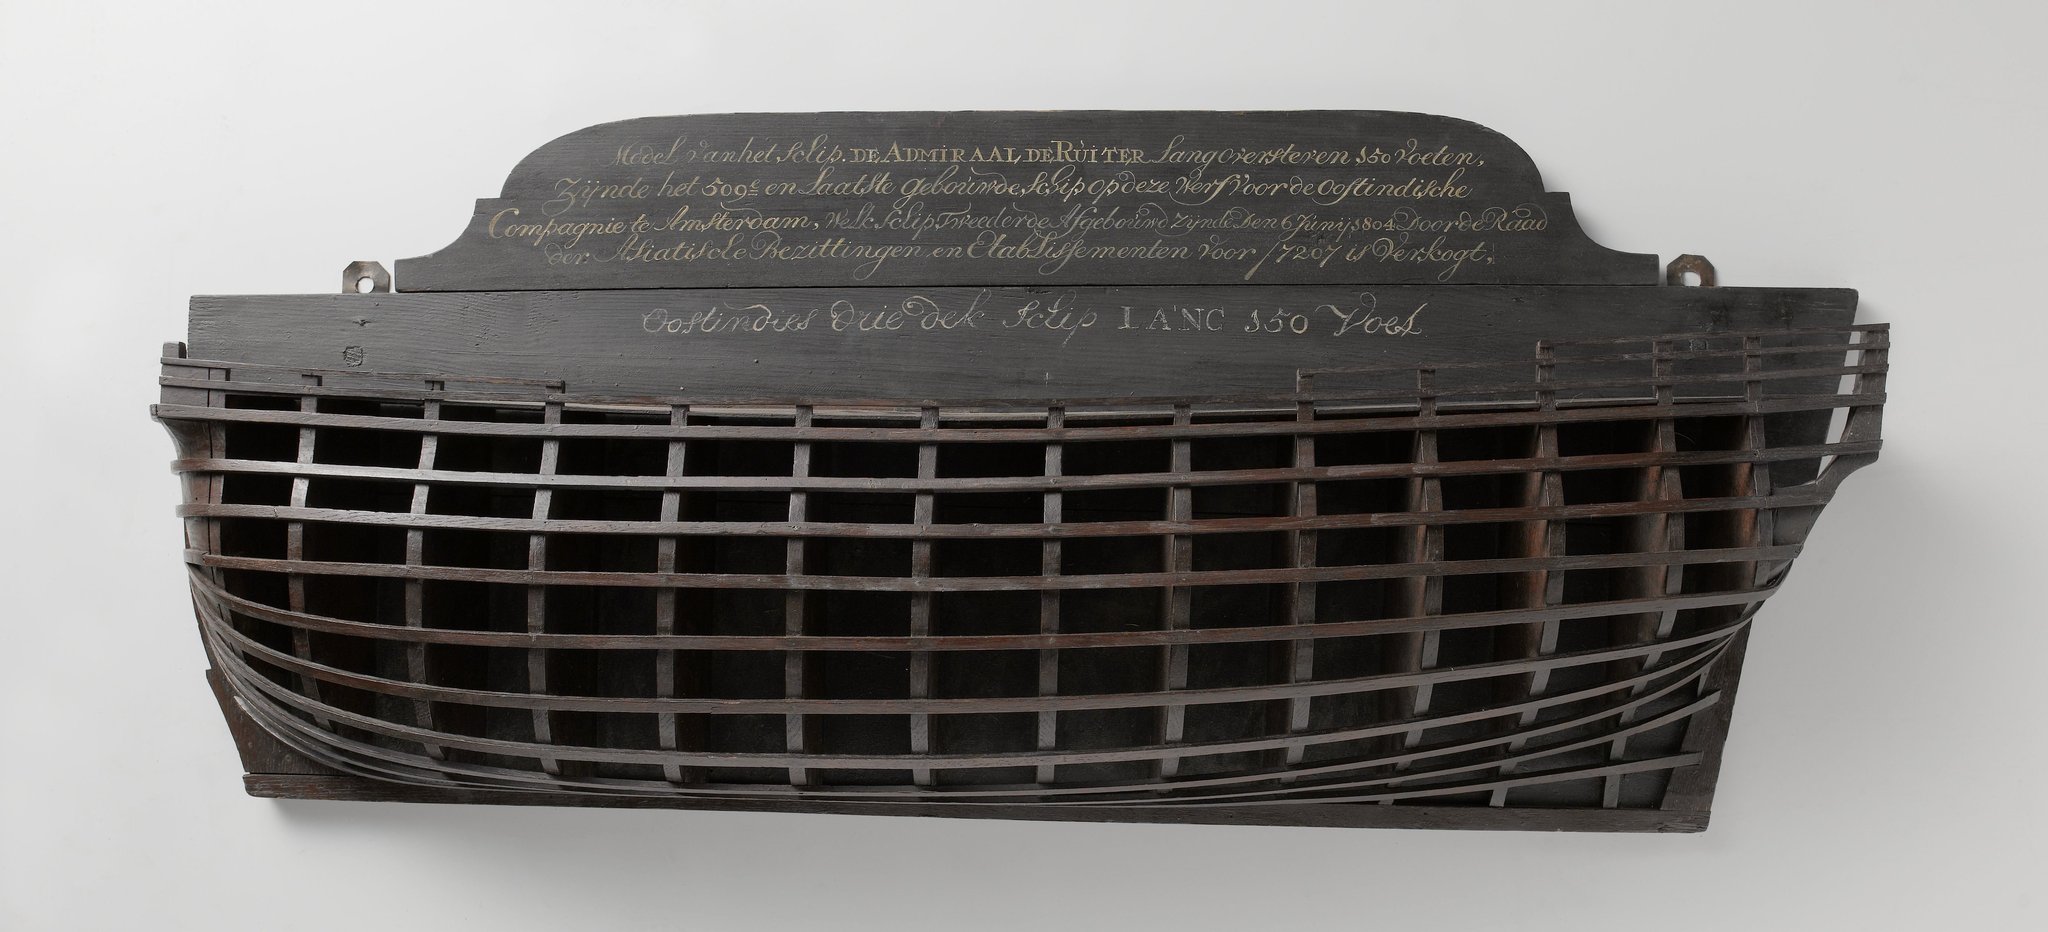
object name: ship model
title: Half Model of an East Indiaman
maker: Anonymous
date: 1800-1804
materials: wood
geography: amsterdam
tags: verenigde oostindische compagnie, admiraal de ruyter (schip)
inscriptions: inscription: ‘Model van het schip DE ADMIRAAL DE RÙITER. Lang oversteven 350 voeten. Zijnde het 509e en laatste gebouwde schip op deze werf voor de Oostindische Compagnie te Amsterdam, welk schip tweederde afgebouwd zijnde den 6e julij 1804 door de Raad der Asiatische Bezittingen en Etablissementen voor f 7207 is verkogt. Oostindies driedek schip LANG 350 voet’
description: Halfmodel van een schip, waarschijnlijk het laatste voor de VOC gebouwd, met de naam Admiraal de Ruyter.